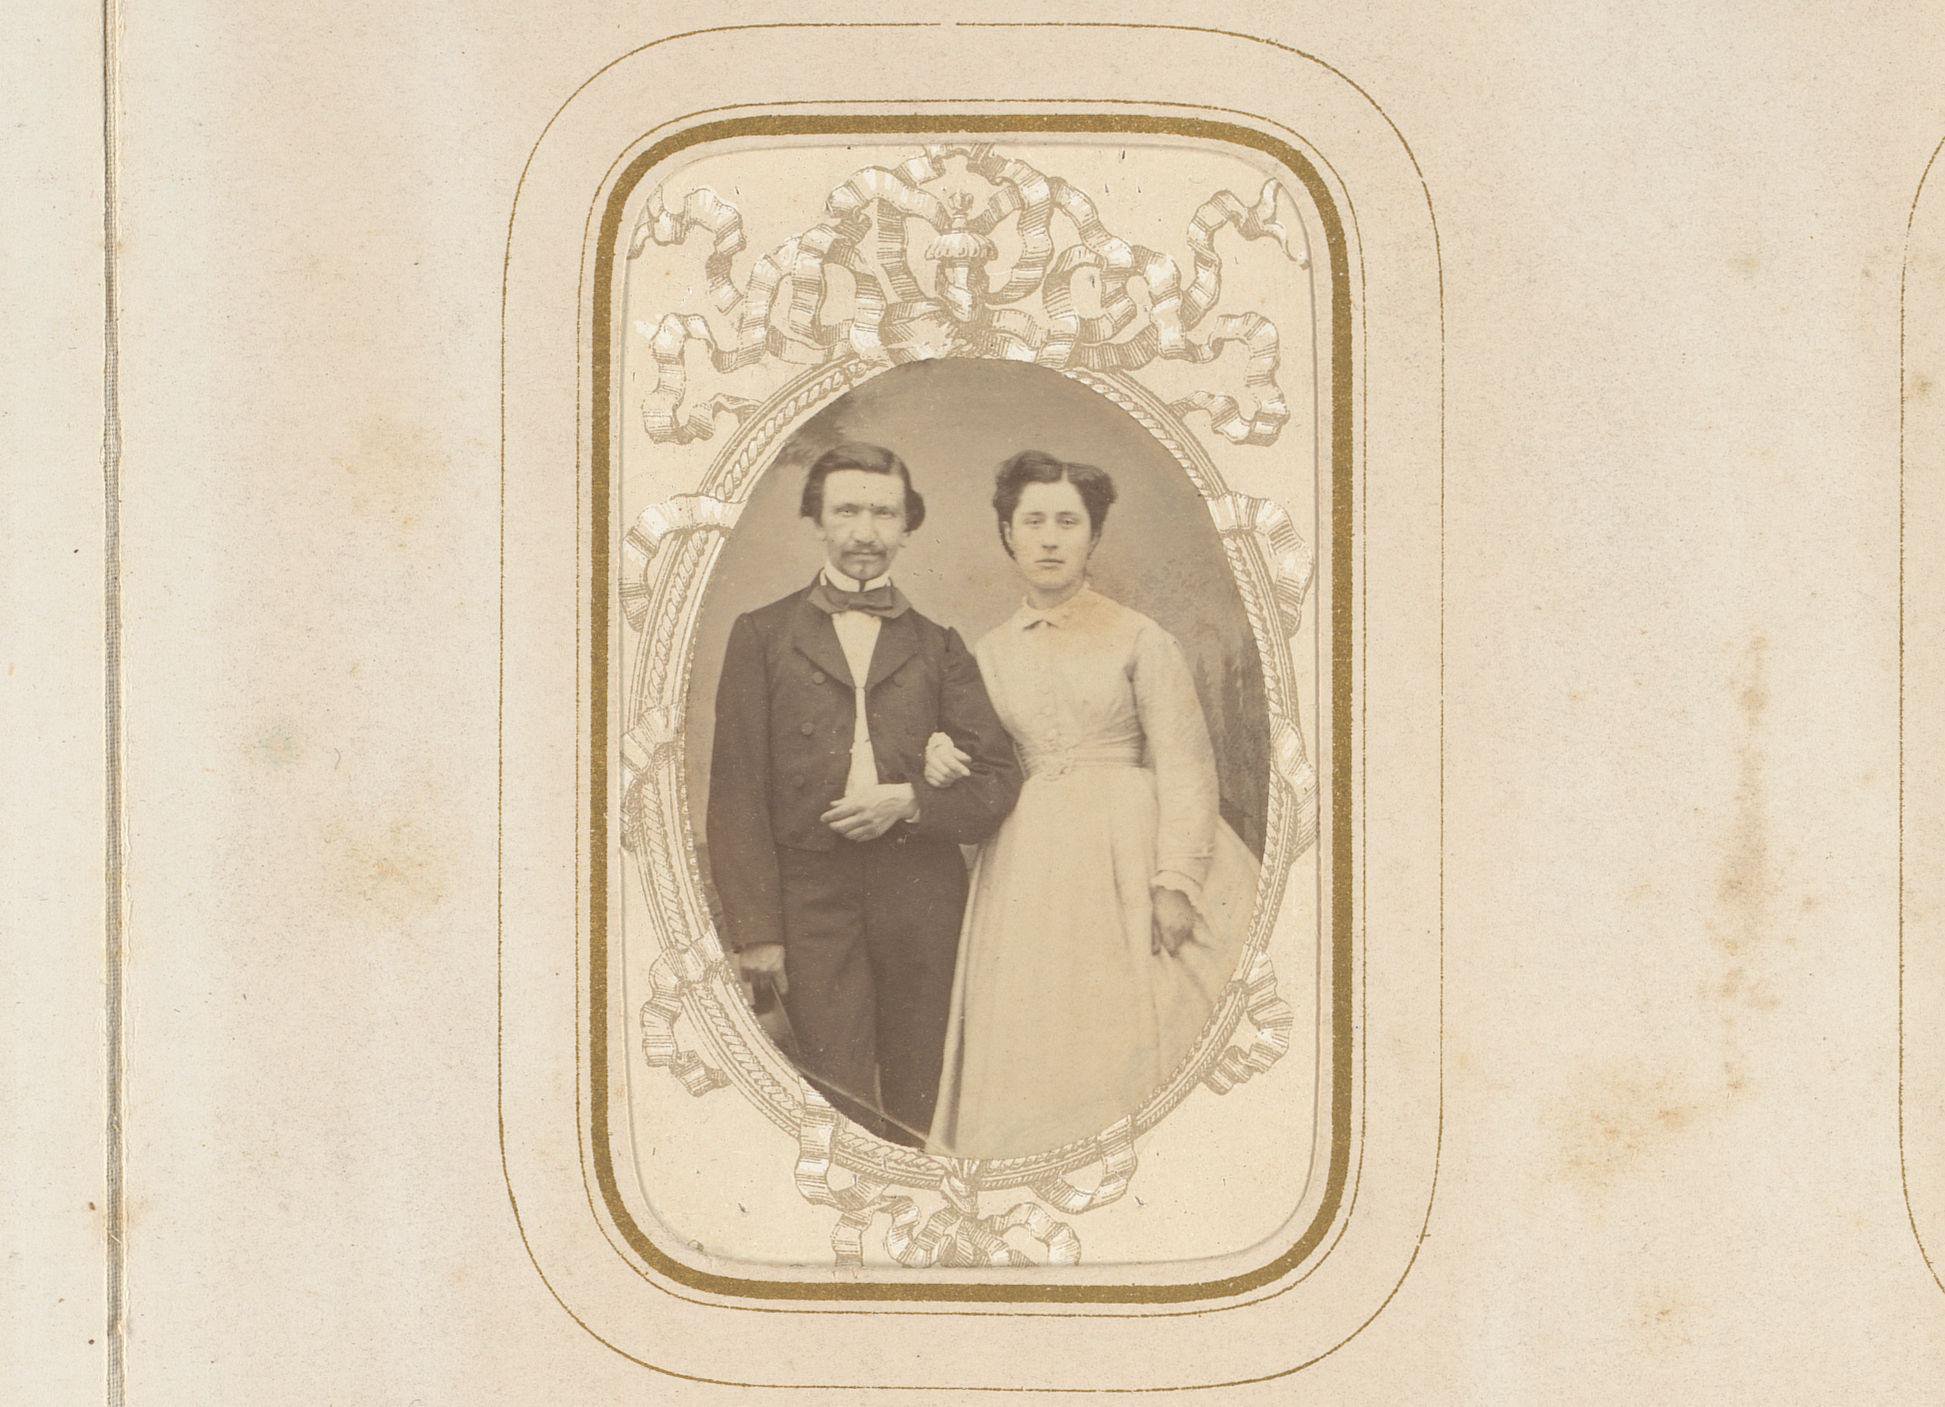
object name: carte de visite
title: Portret van een echtpaar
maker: Anonymous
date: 1860-1890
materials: cardboard, photographic support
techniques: albumen print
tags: historical persons - bb - woman, historical persons, arm in arm (lovers)